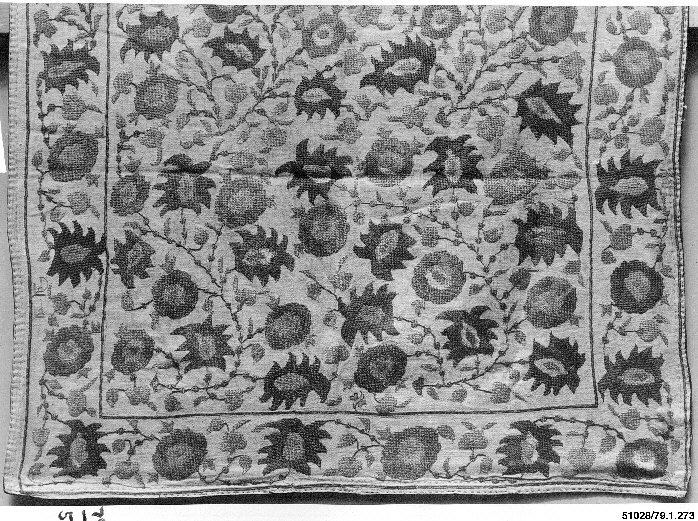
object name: cover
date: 1801-1833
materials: linen, silk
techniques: embroidery, weave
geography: turkey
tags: flowers